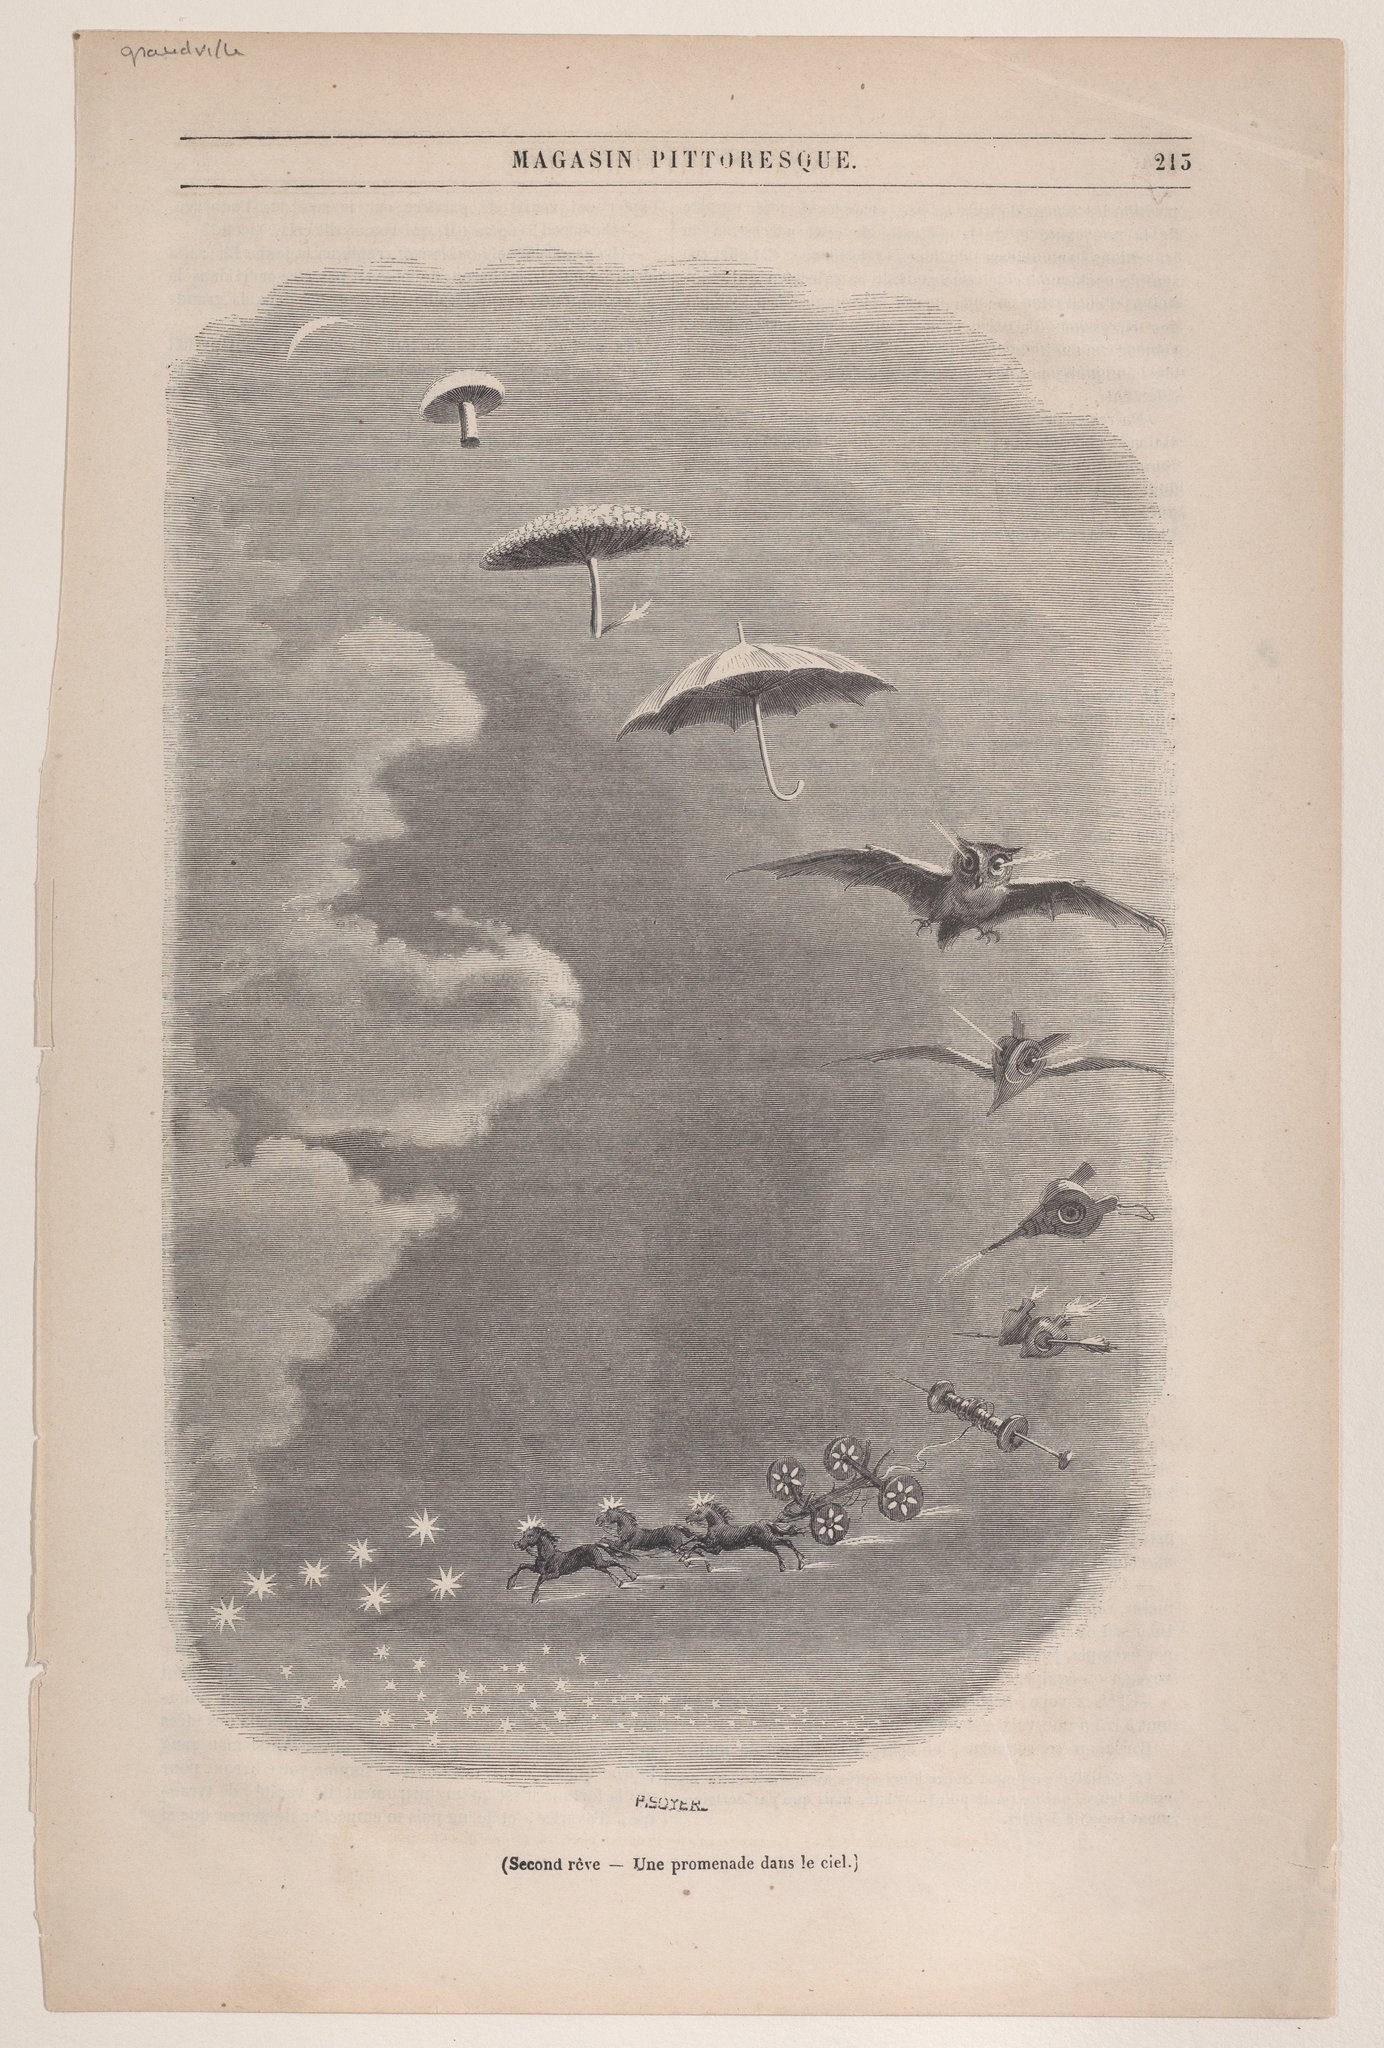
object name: print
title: Second Dream, from "Le Magasin Pittoresque"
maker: j. j. grandville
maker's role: artist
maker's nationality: french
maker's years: 1803-1847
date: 1820-1847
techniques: engraving